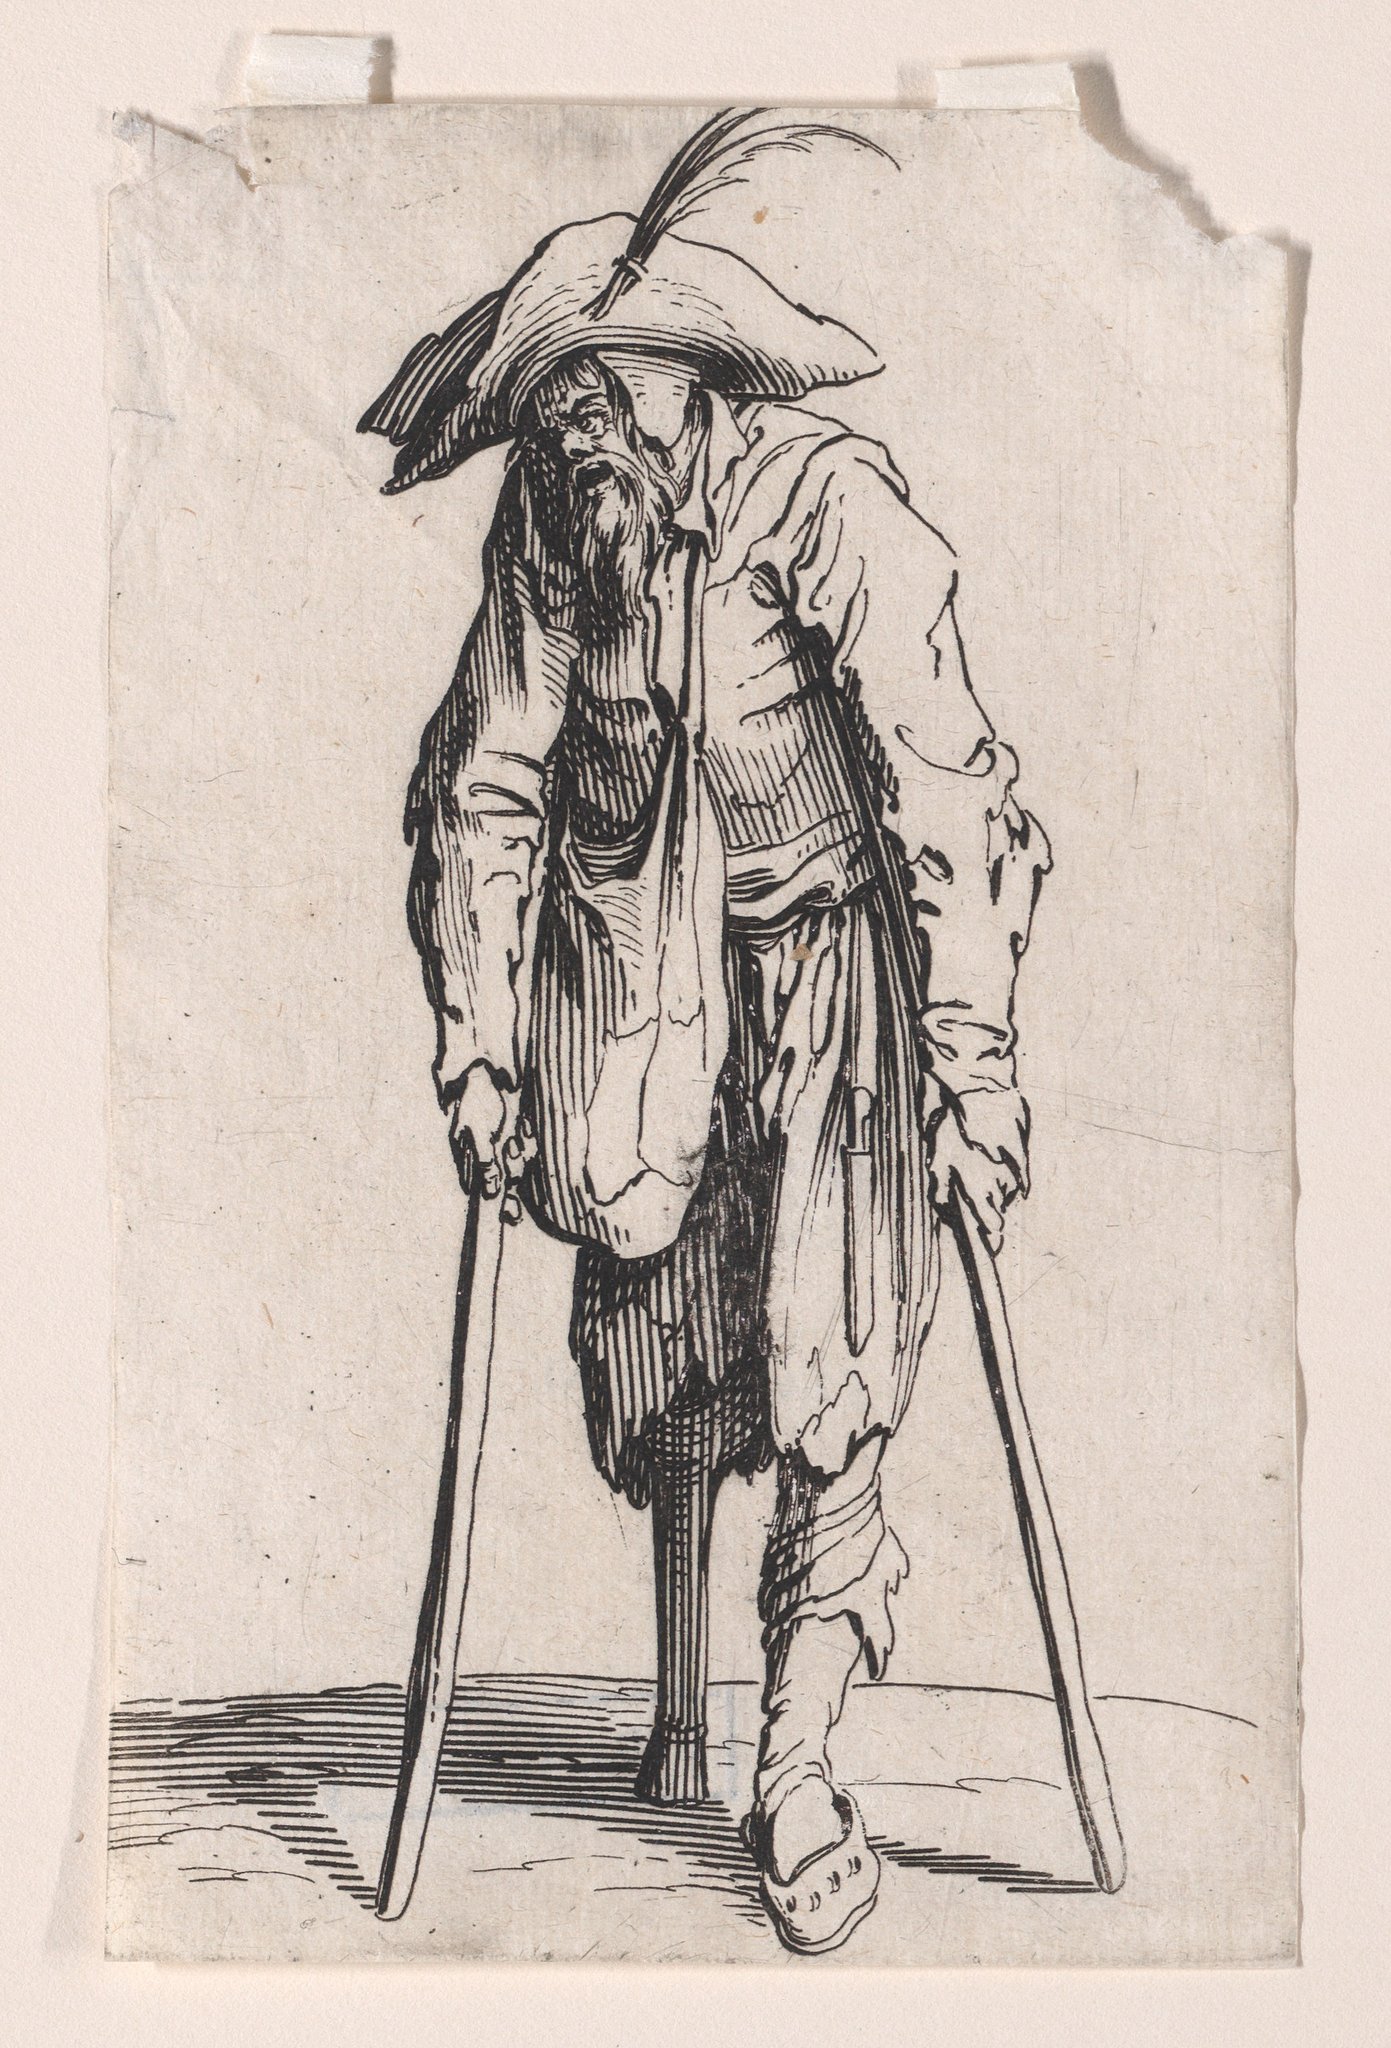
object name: print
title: Le Mendiant a la Jambe de Bois (The Beggar with the Wooden Leg), from "Les Gueux suite appelée aussi Les Mendiants, Les Baroni, ou Les Barons" (The Beggars, also called the Barons)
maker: jacques callot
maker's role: artist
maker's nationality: french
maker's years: 1592-1635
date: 1623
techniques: etching